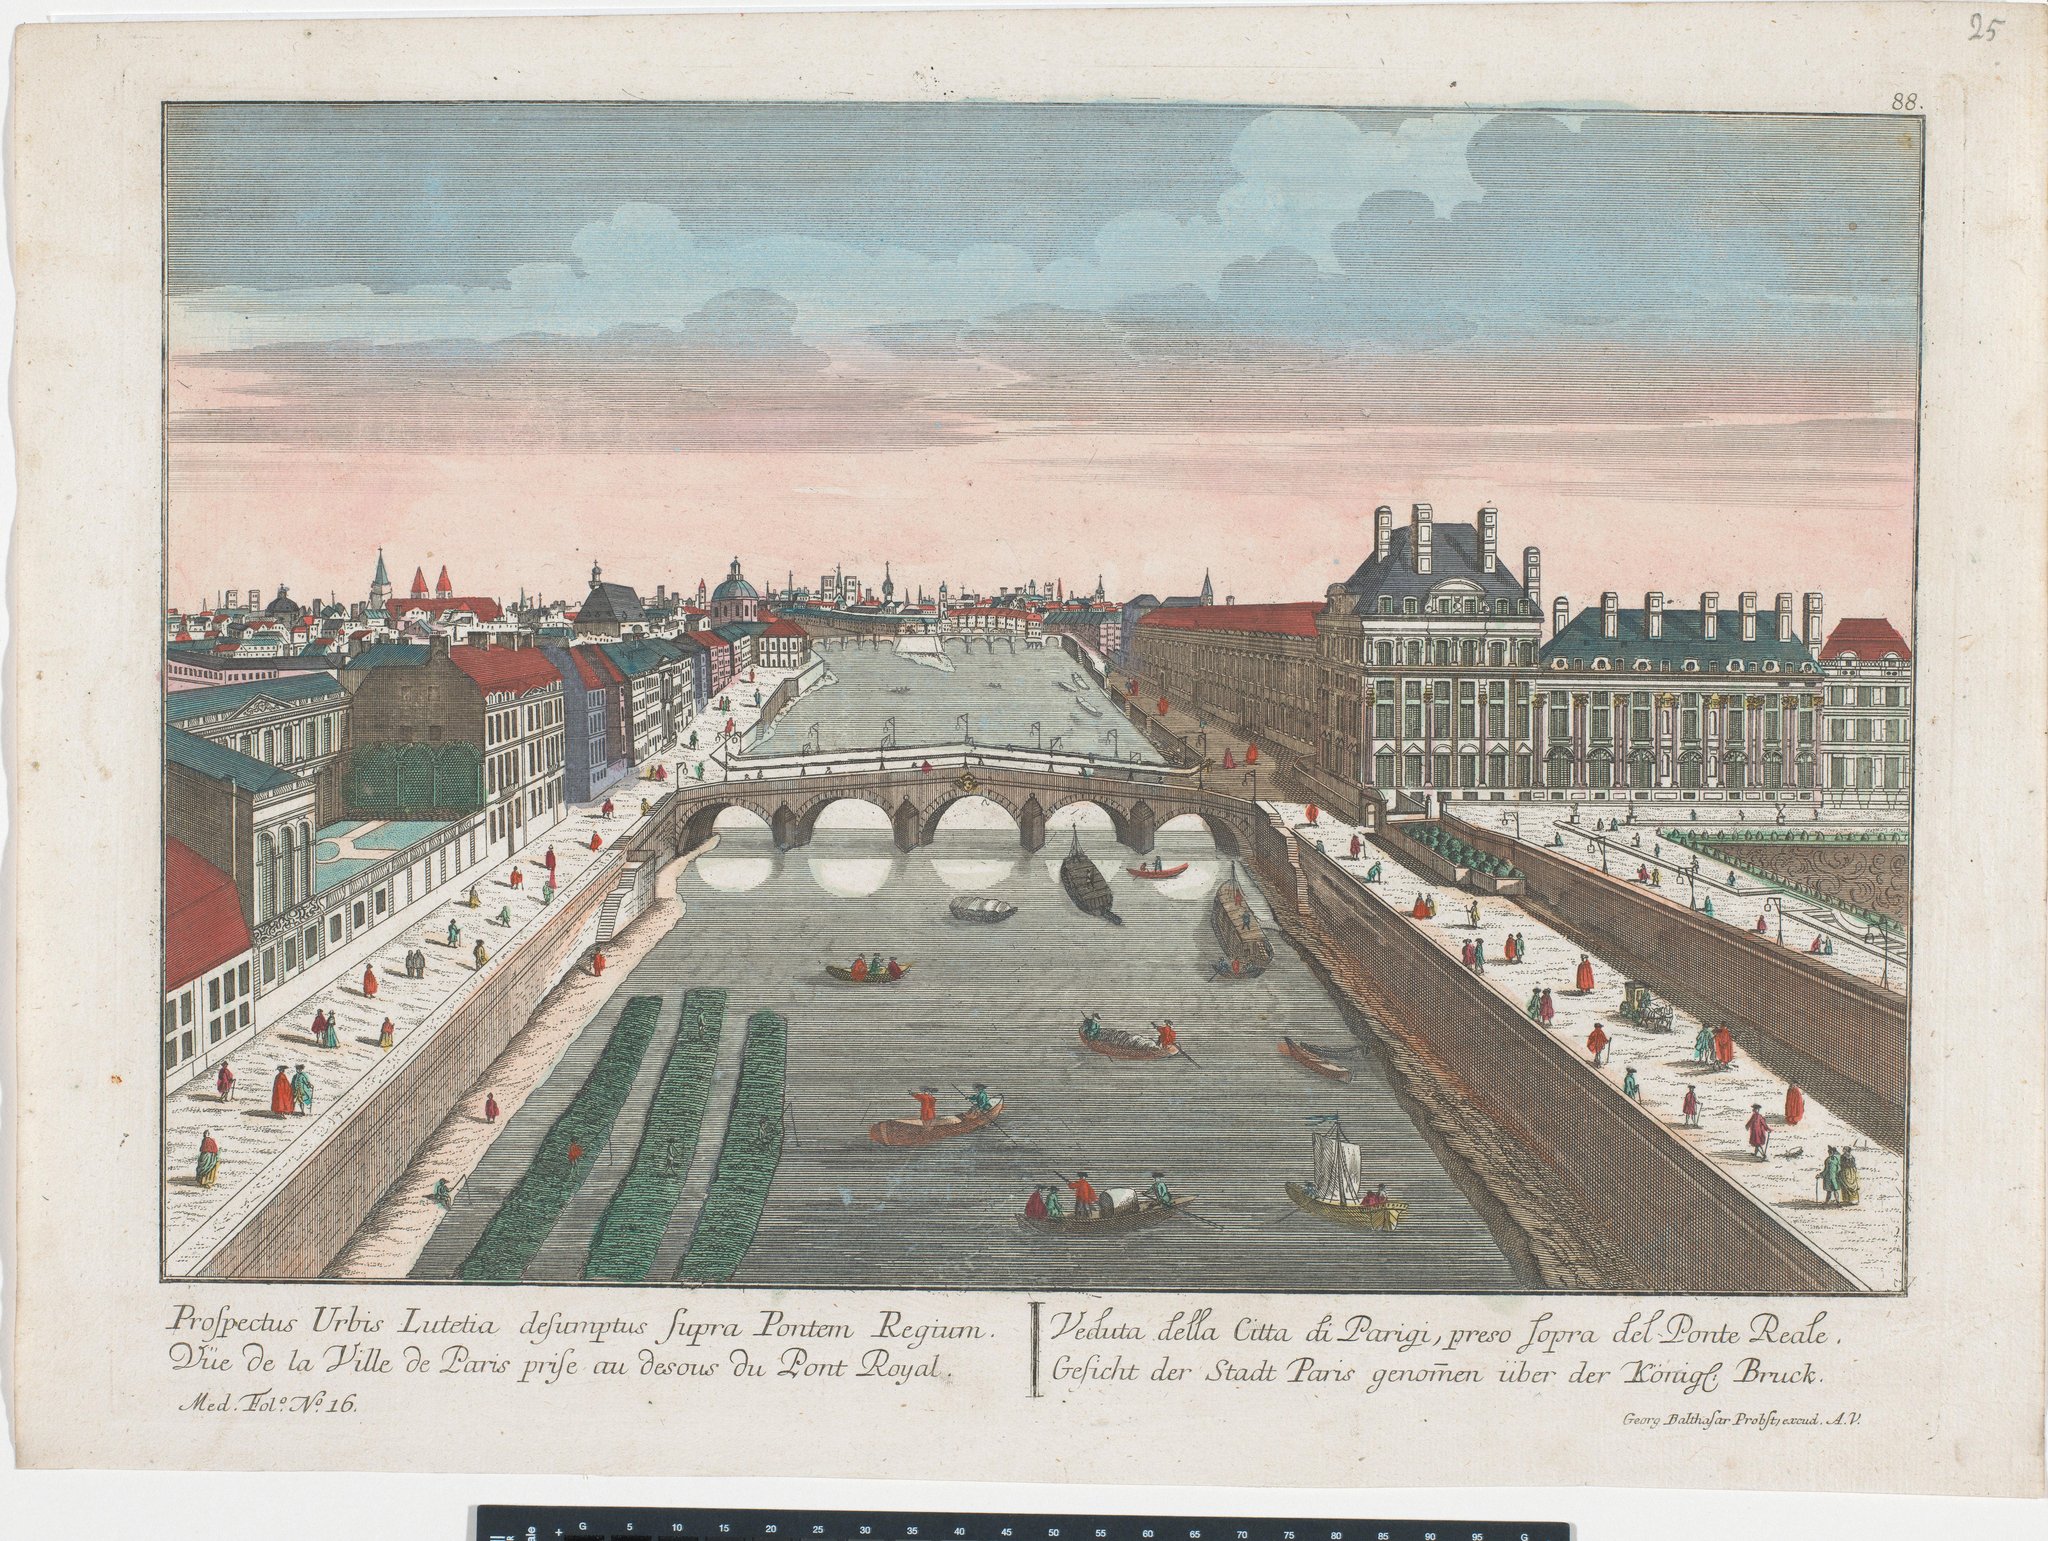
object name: opticaprent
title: Gesicht der Stadt Paris genommen über der Königl. Bruck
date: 1742-1801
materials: paper, watercolor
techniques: brush, etching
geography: germany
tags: bridge in city across river, canal, etc. (+ city(-scape) with figures, staffage), palace, rowing-boat, canoe, etc., tuileries palace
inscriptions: watermark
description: De serie “Parijs”, met het nummer 16, bevat vier prenten met de nummers 87-90, waarvan dit nummer 88 is.